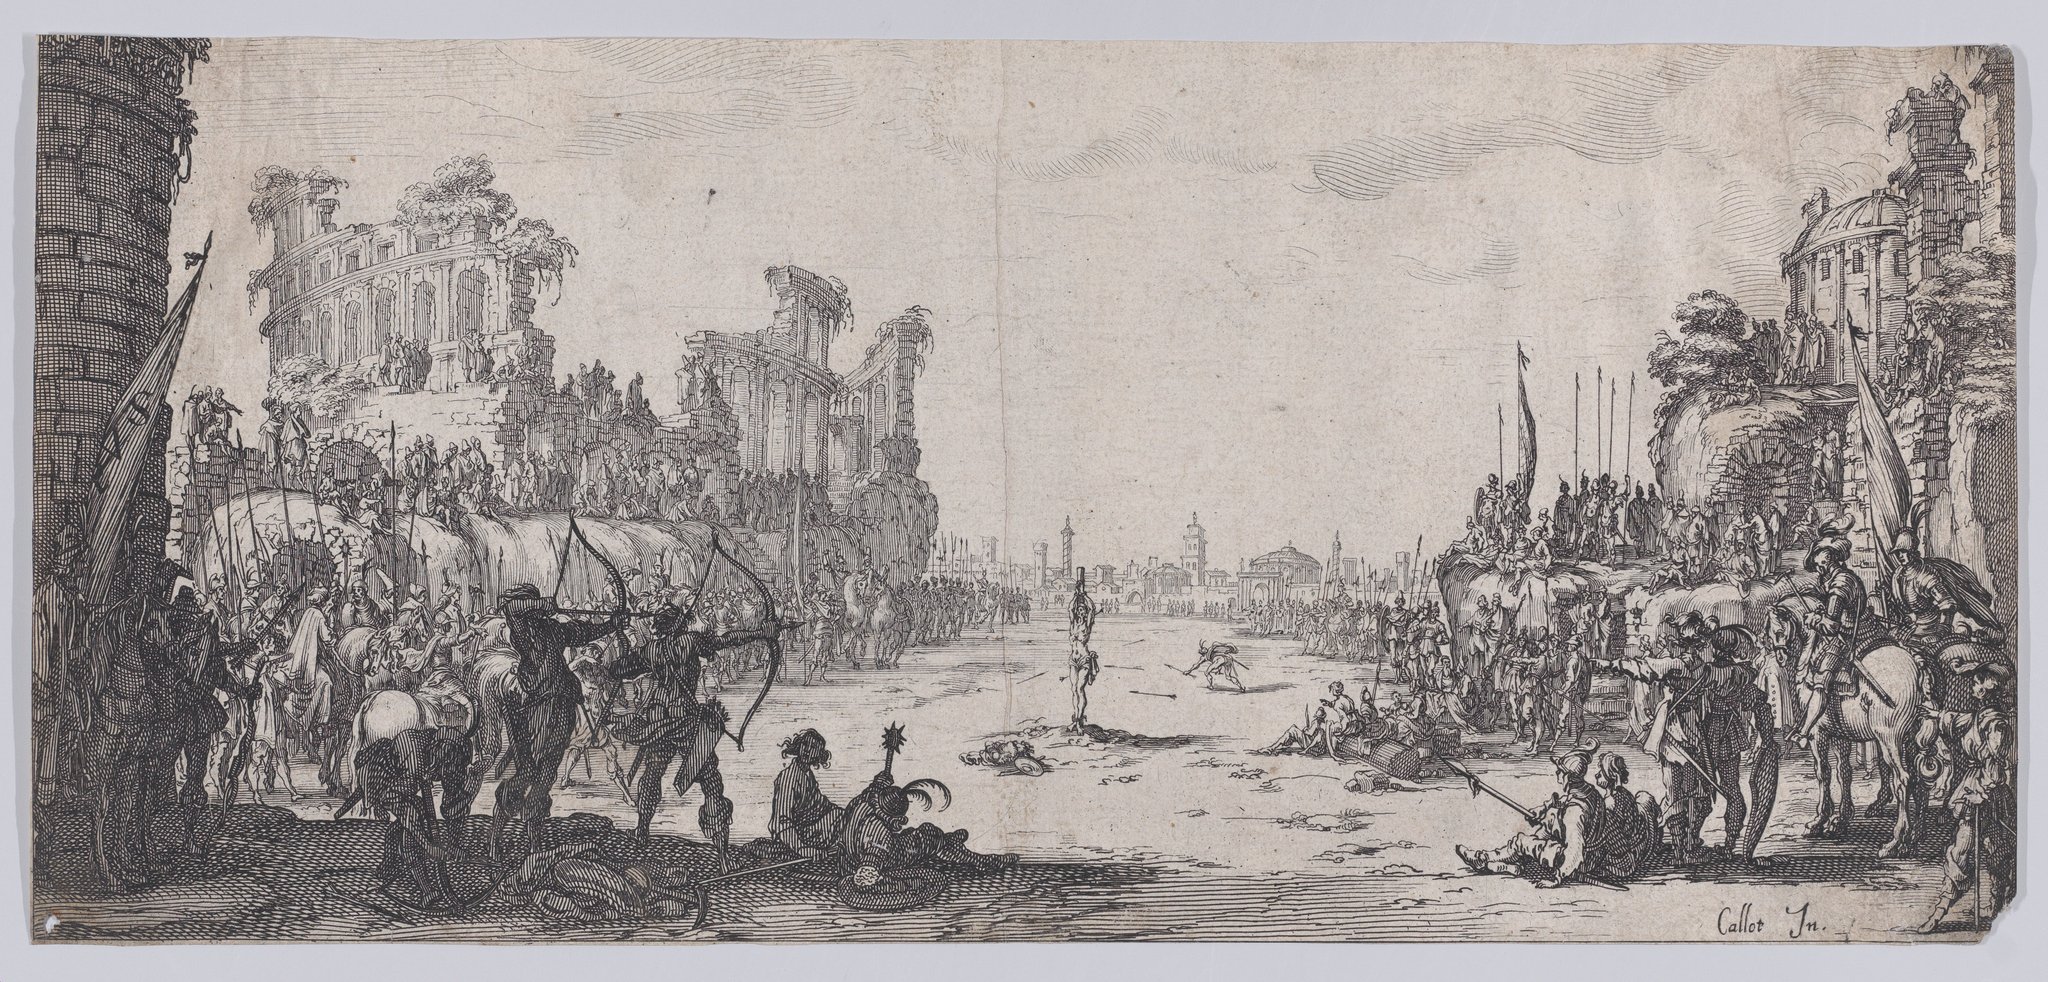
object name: print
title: Copy of Le Martyre de St. Sébastien (The Martyrdom of St. Sebastian)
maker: Anonymous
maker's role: artist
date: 1601-1700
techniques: etching